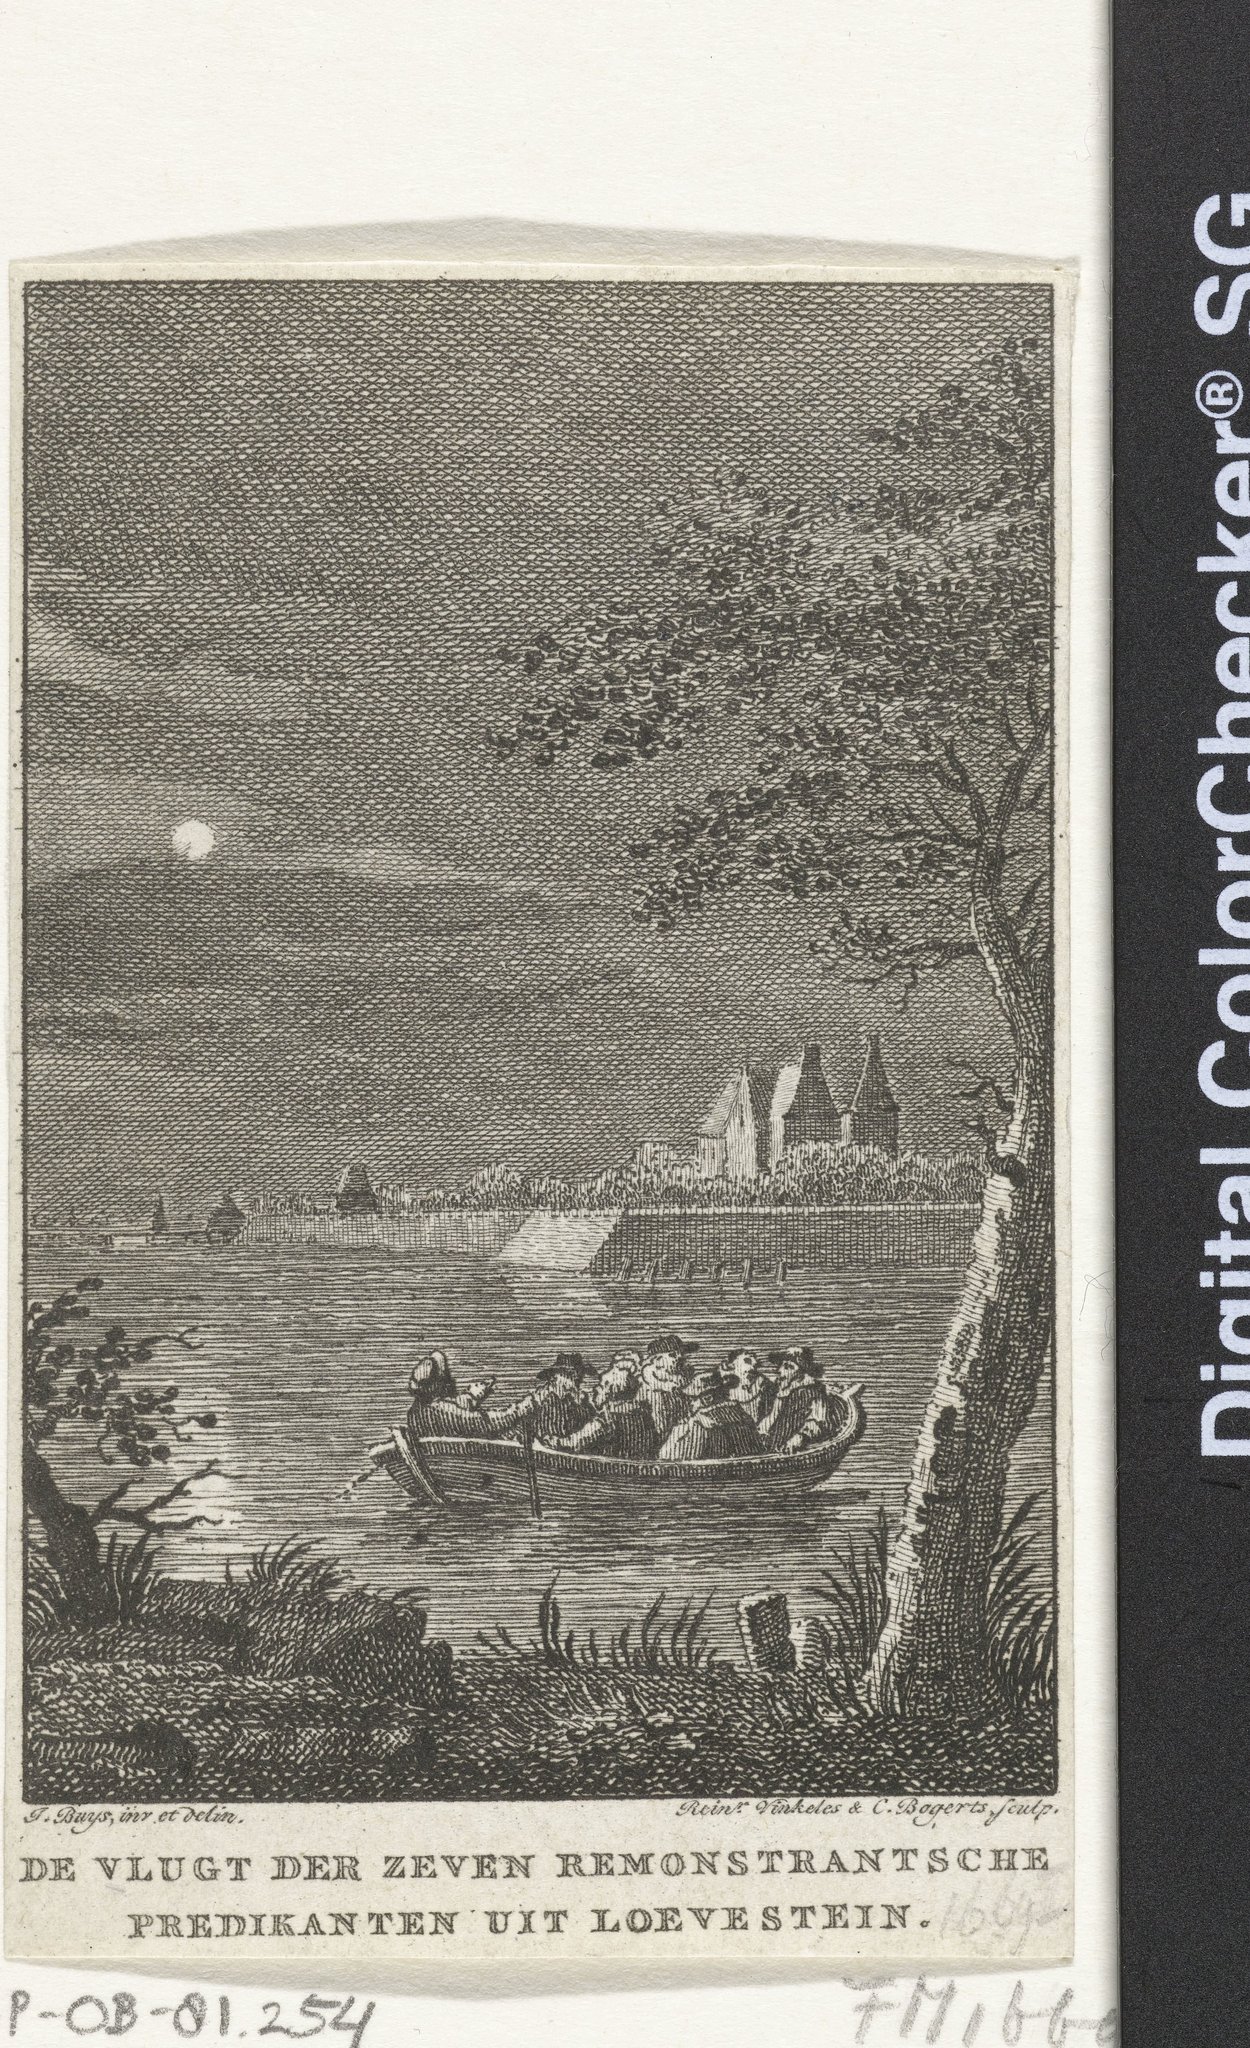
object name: print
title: De vlugt der zeven remonstrantsche predikanten uit Loevestein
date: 1780-1795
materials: paper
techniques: etching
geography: northern netherlands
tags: law and jurisprudence (+ escape from prison), loevestein castle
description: Gebruikt als illustratie in: J. Fokke, Geschiedenissen der Vereenigde Nederlanden voor de vaderlandsche jeugd, Johannes Allart, Amsterdam 1783-1795, 25 delen, dl. VIII, pl. I. Niet in Frederik Muller; door het RPK toegevoegd nummer.